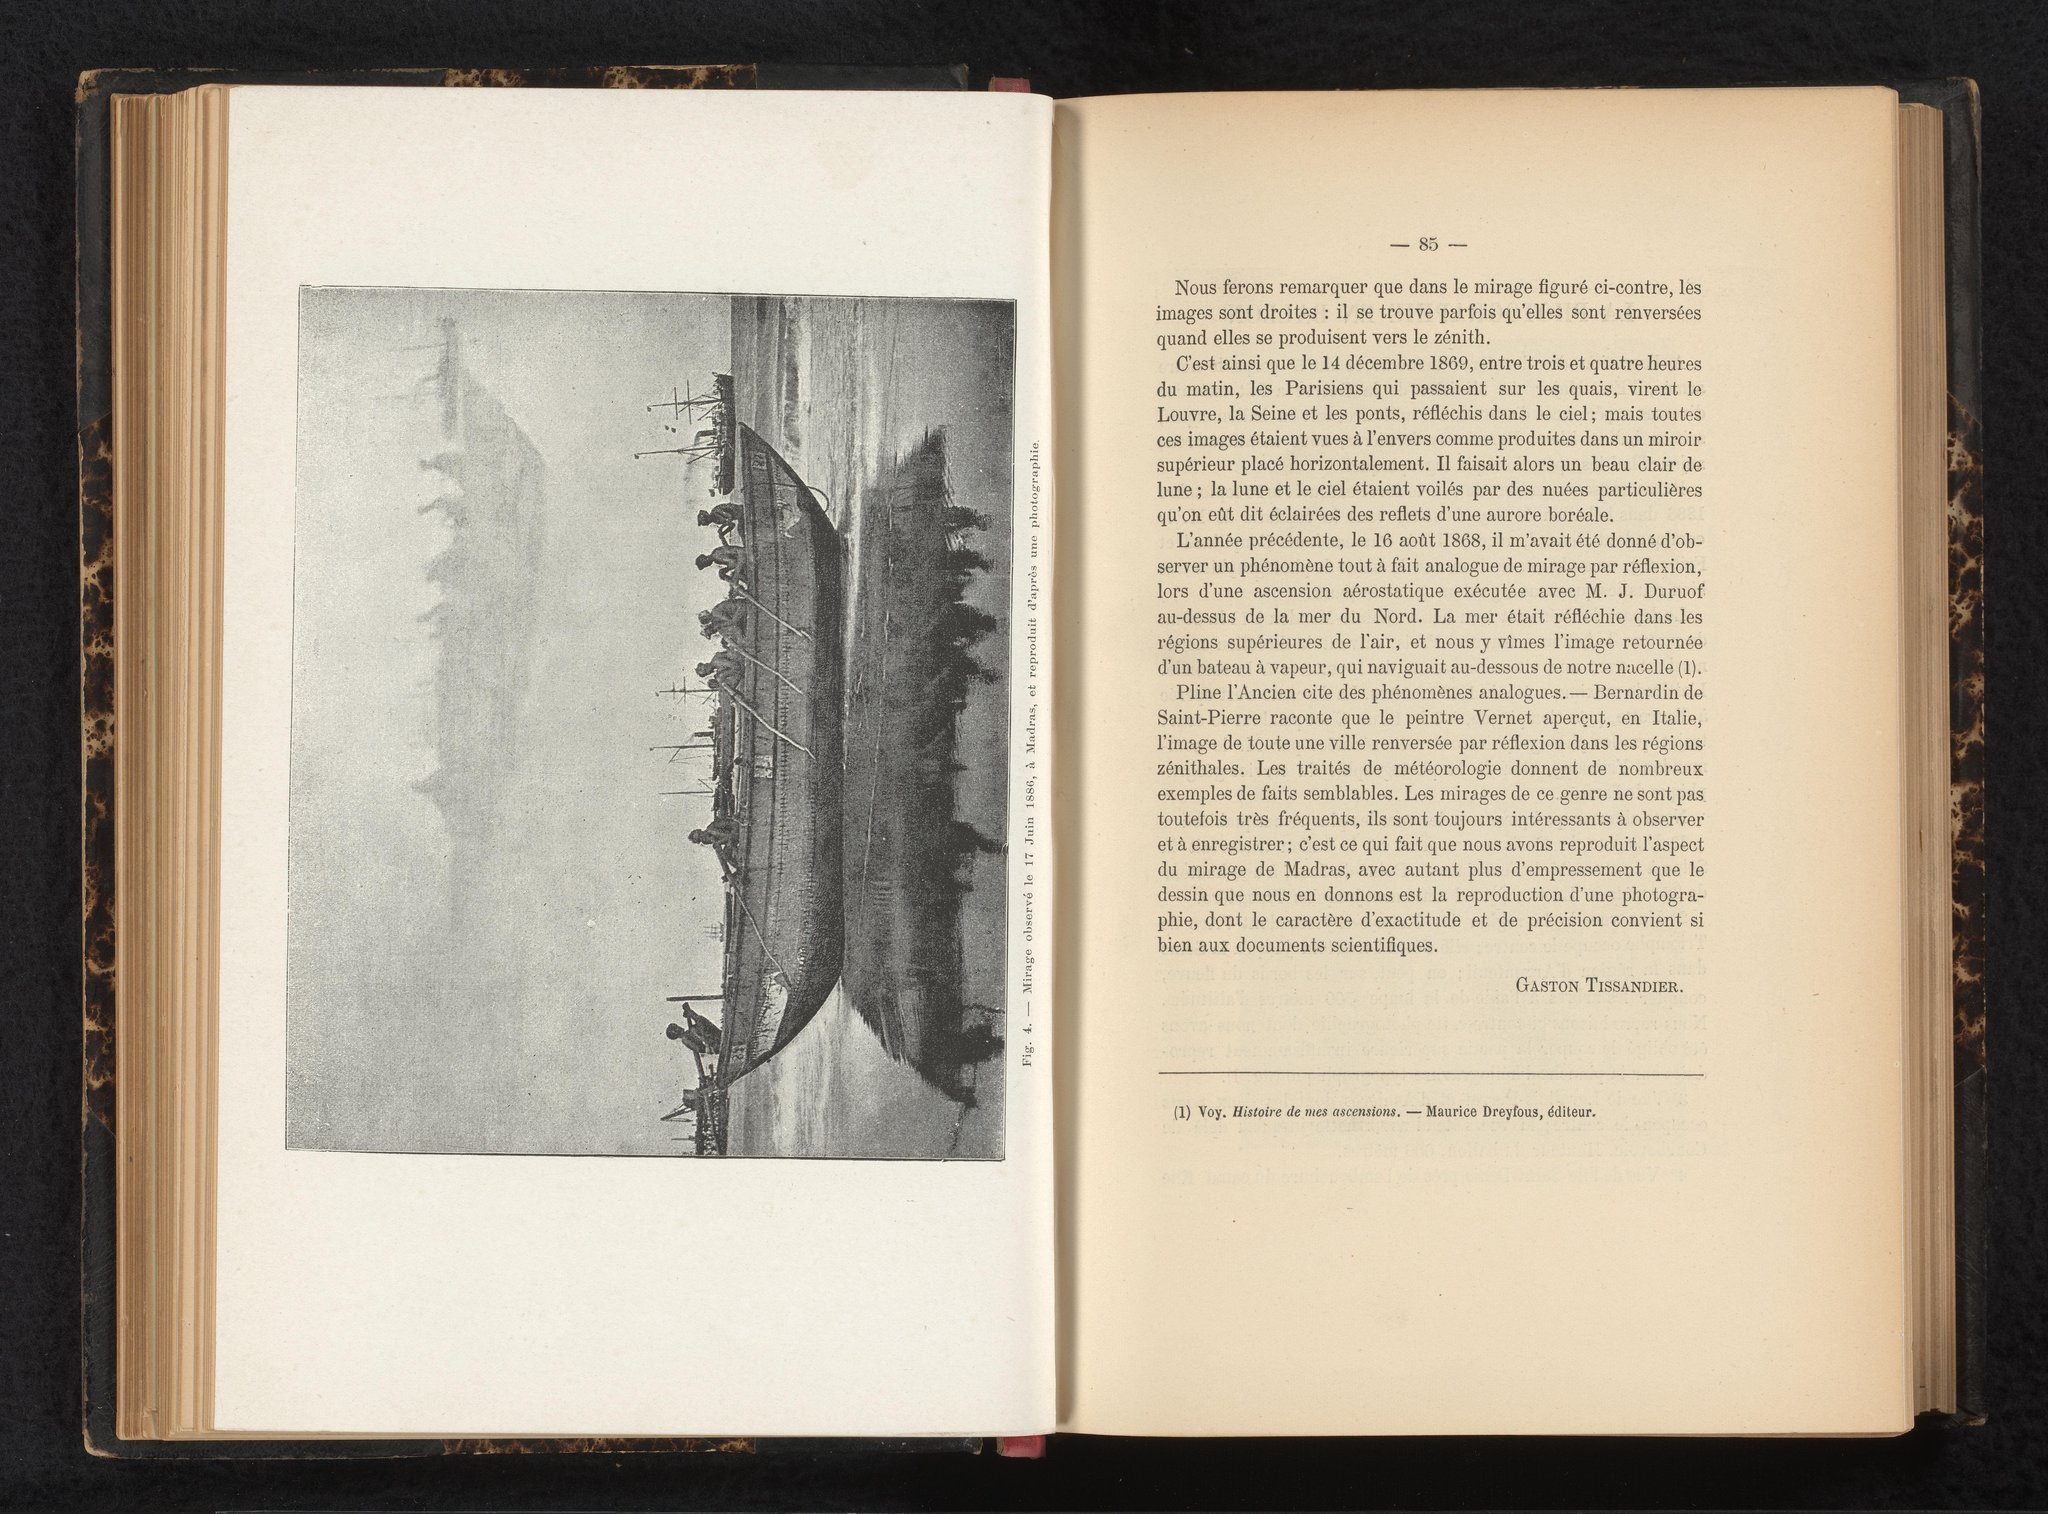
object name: photomechanical print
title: Mirage observé le 17 juin 1886, à Madras, et reproduit d'après une photographie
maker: Anonymous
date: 1886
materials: paper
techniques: autotype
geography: chennai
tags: mirage, 'fata morgana', rowing facing backward, pulling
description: Prent op ongenummerde pagina tegenover pagina 85.